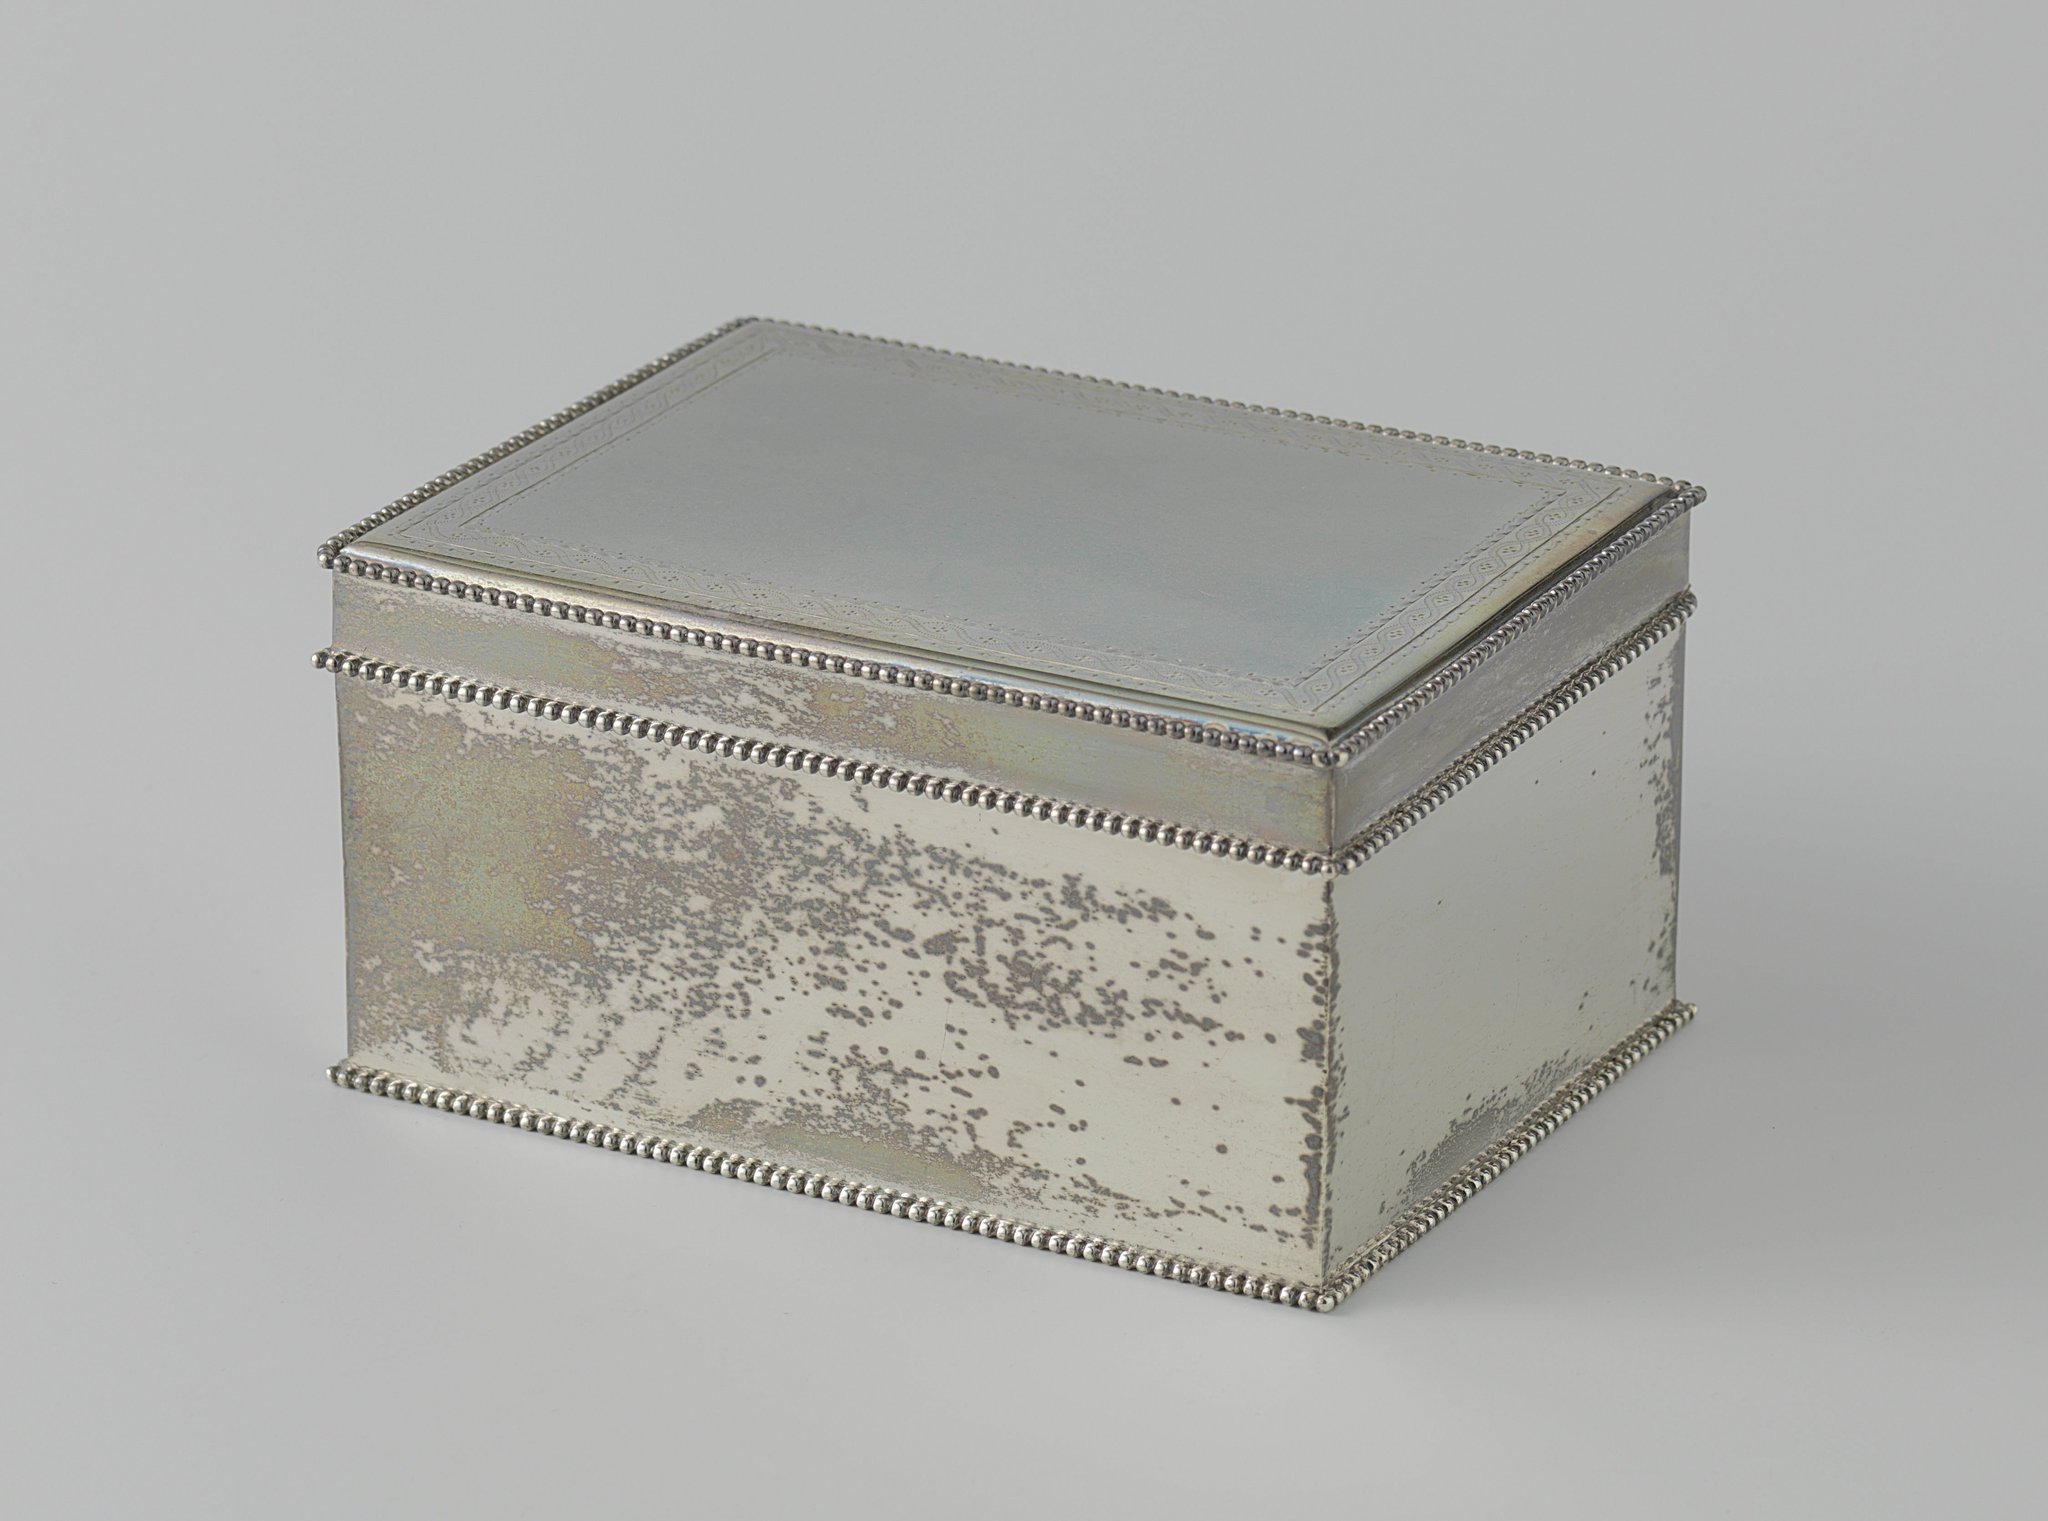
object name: tin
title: Biscuit container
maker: diederik willem rethmeyer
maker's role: silversmith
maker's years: 1756-1821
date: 1791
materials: silver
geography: amsterdam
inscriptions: alloy mark, date letter: ‘G’, : ‘L’, town mark, maker's mark, duty mark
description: These two plain containers are decorated only with a beaded edge. Their form is determined by their function. During dessert, biscuits were served from the round container, and 'oublies' (small rolled-up waffles) from the rectangular one. Such silver biscuit containers almost always come in pairs and are a typically Dutch phenomenon. Their shape may have been derived from simpler models made of tin.